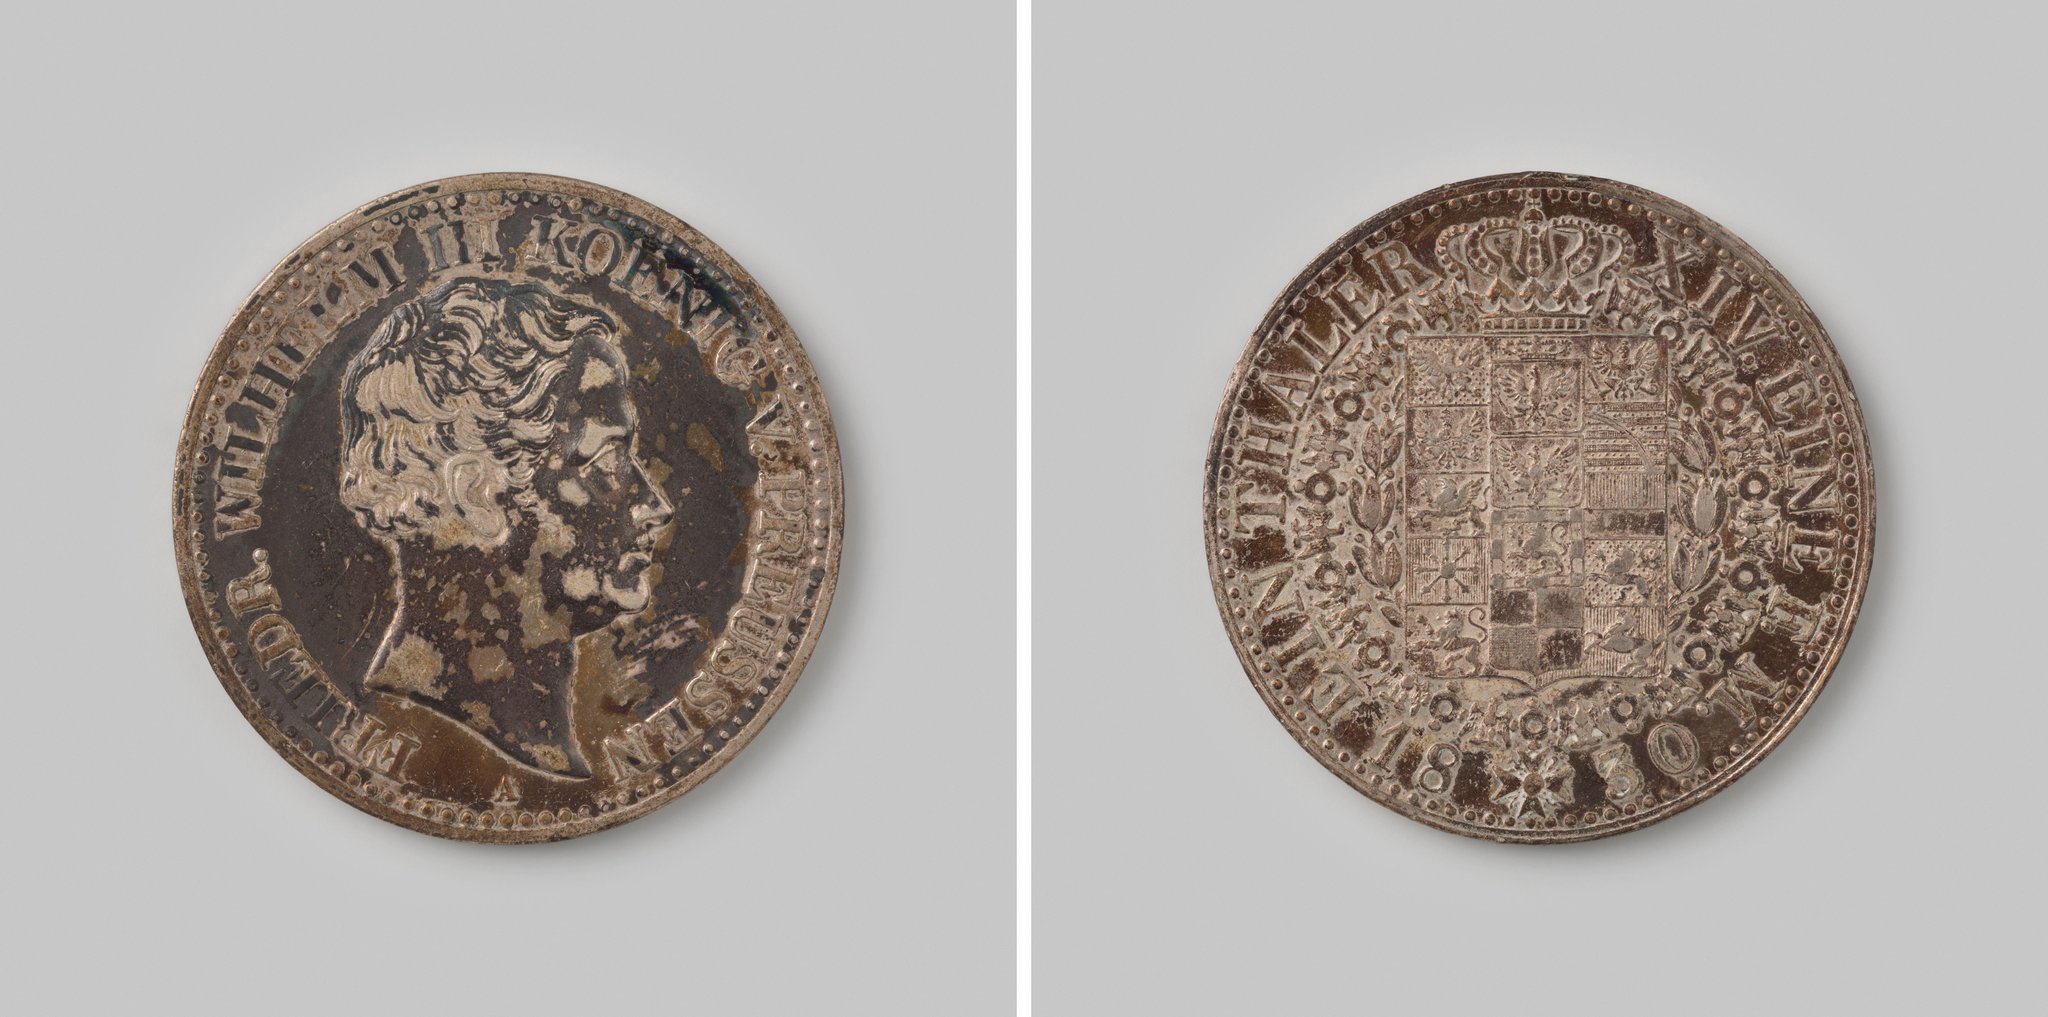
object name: taler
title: Taler uit Pruisen van Friedrich Wilhelm III, 1830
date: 1830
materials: silver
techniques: striking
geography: berlin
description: Zilveren munt. Voorzijde: hoofd van de koning naar rechts. Daaronder letter A. Keerzijde: door keten en juweel van ridderorde omhangen versierd gekroond samengesteld wapenschild. in omschrift waarde-aanduiding: Ein Thaler en jaartal onderaan. Randschrift.